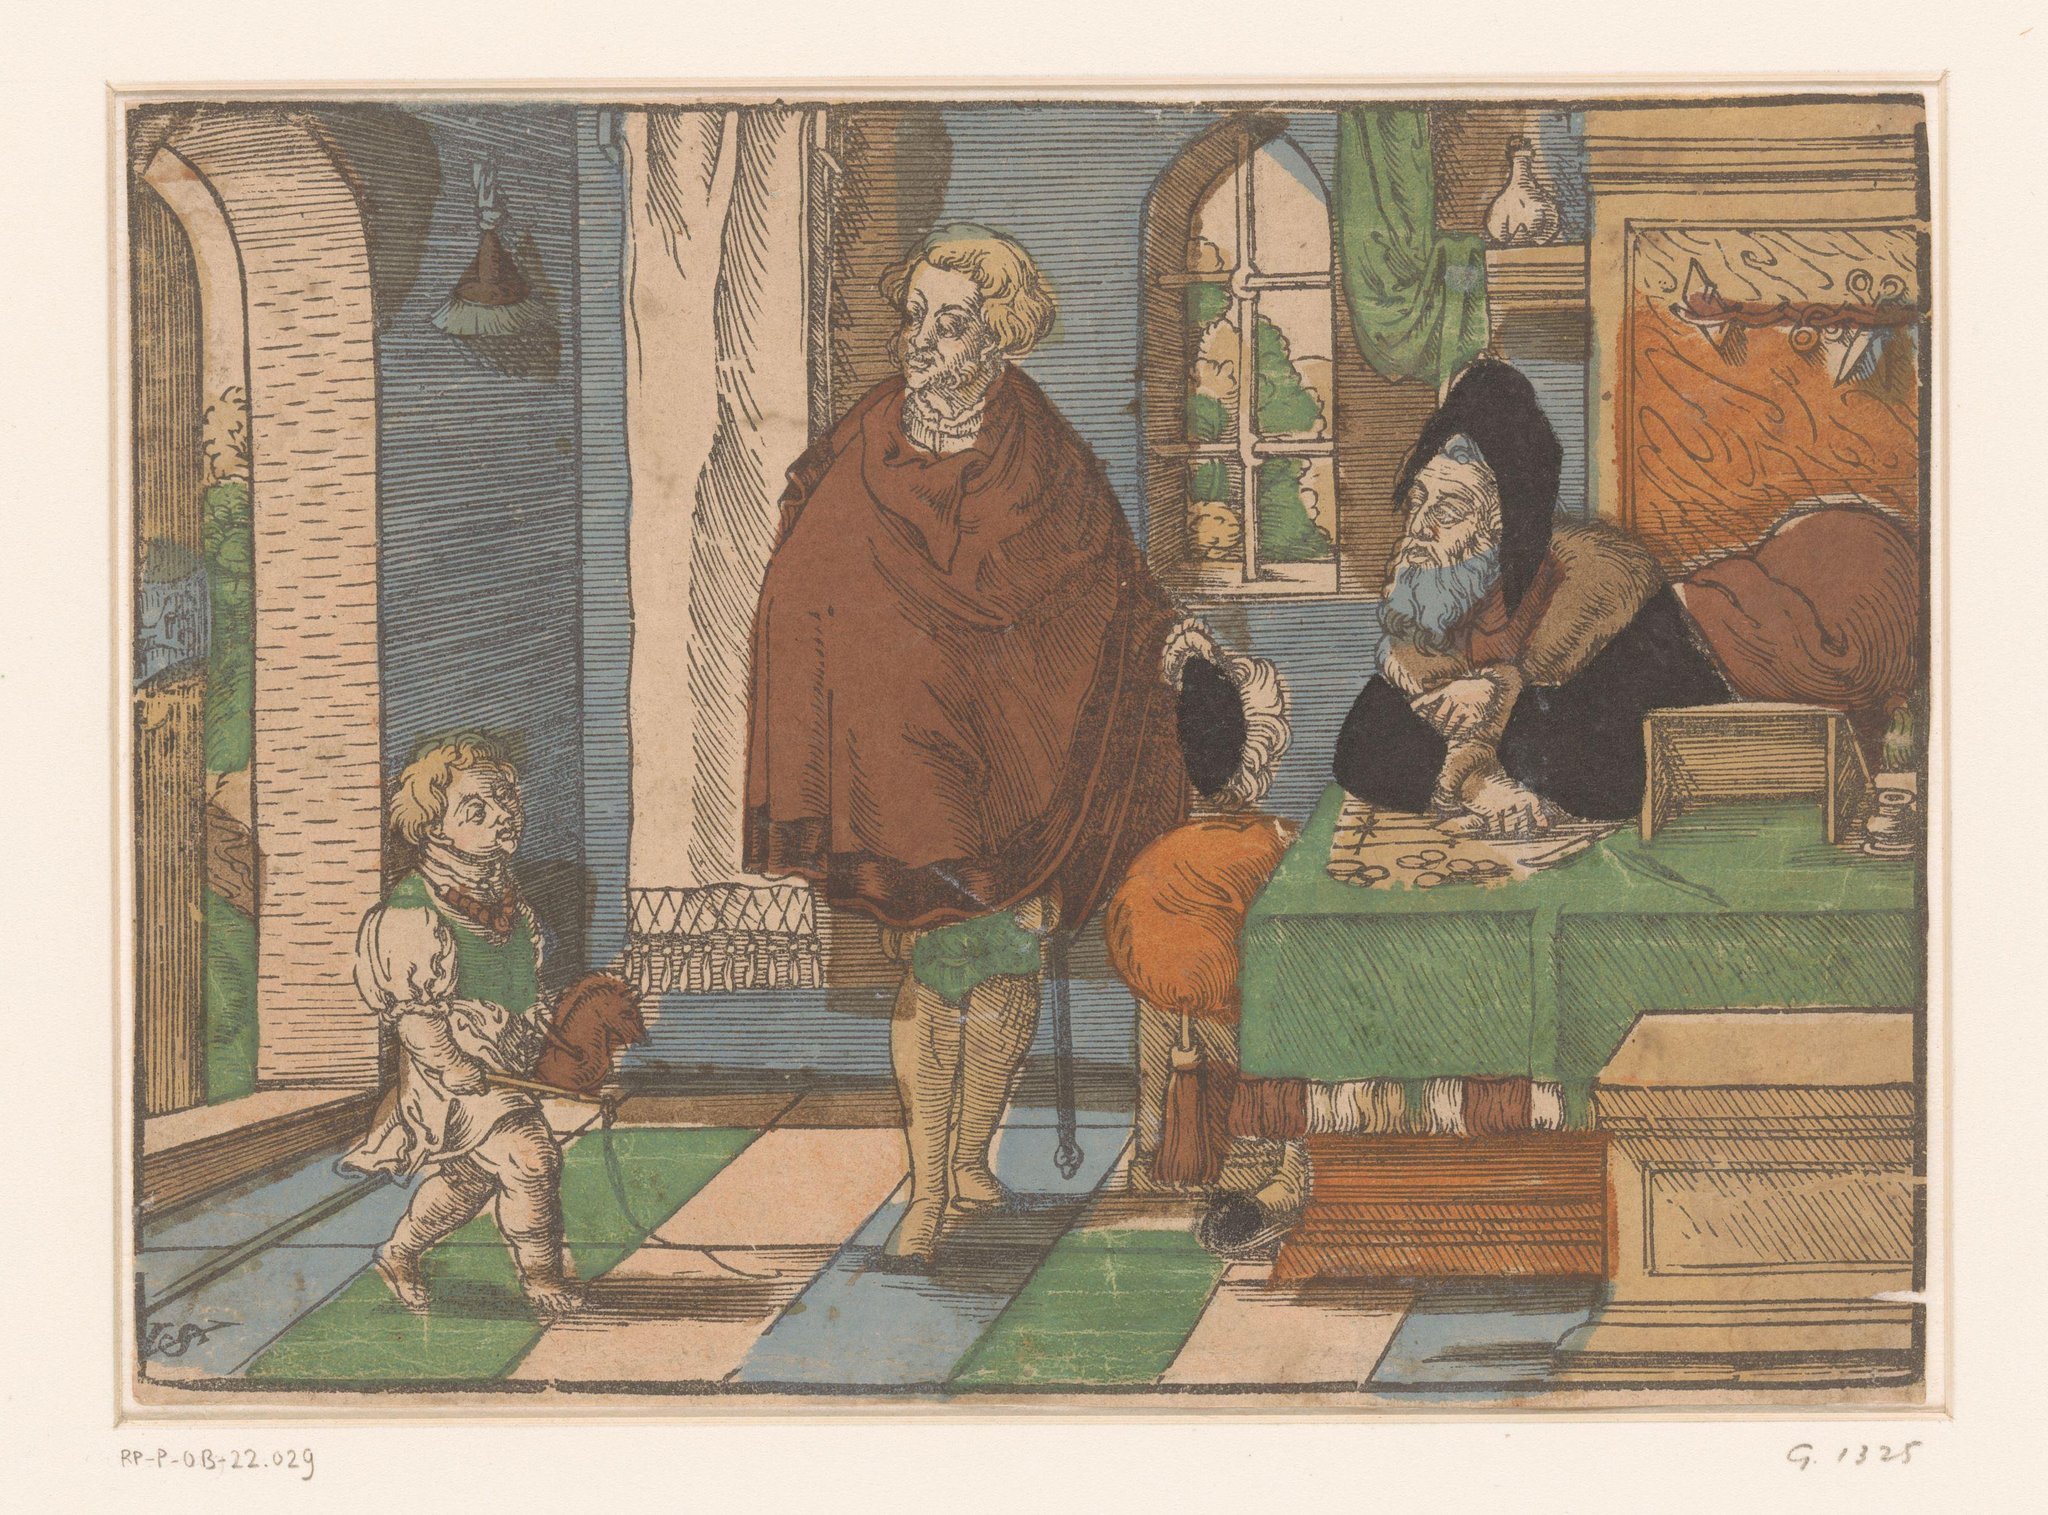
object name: print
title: Interieur met een oude man, jongeman en kind met een stokpaard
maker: virgilius solis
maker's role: draughtsman, print maker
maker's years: 1514-1562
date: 1549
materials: paper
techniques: hand coloring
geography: nuremberg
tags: hobby-horse, child, youth, adolescent, old man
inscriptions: number: ‘186’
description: Prent gebruikt voor een in 1549 gepubliceerd pamflet over huwelijkskandidaten getiteld: Rath zwischen dreyerley Heyrat. Het pamflet bevat een gedicht door Hans Sachs en werd gedrukt door Hans Guldenmund.